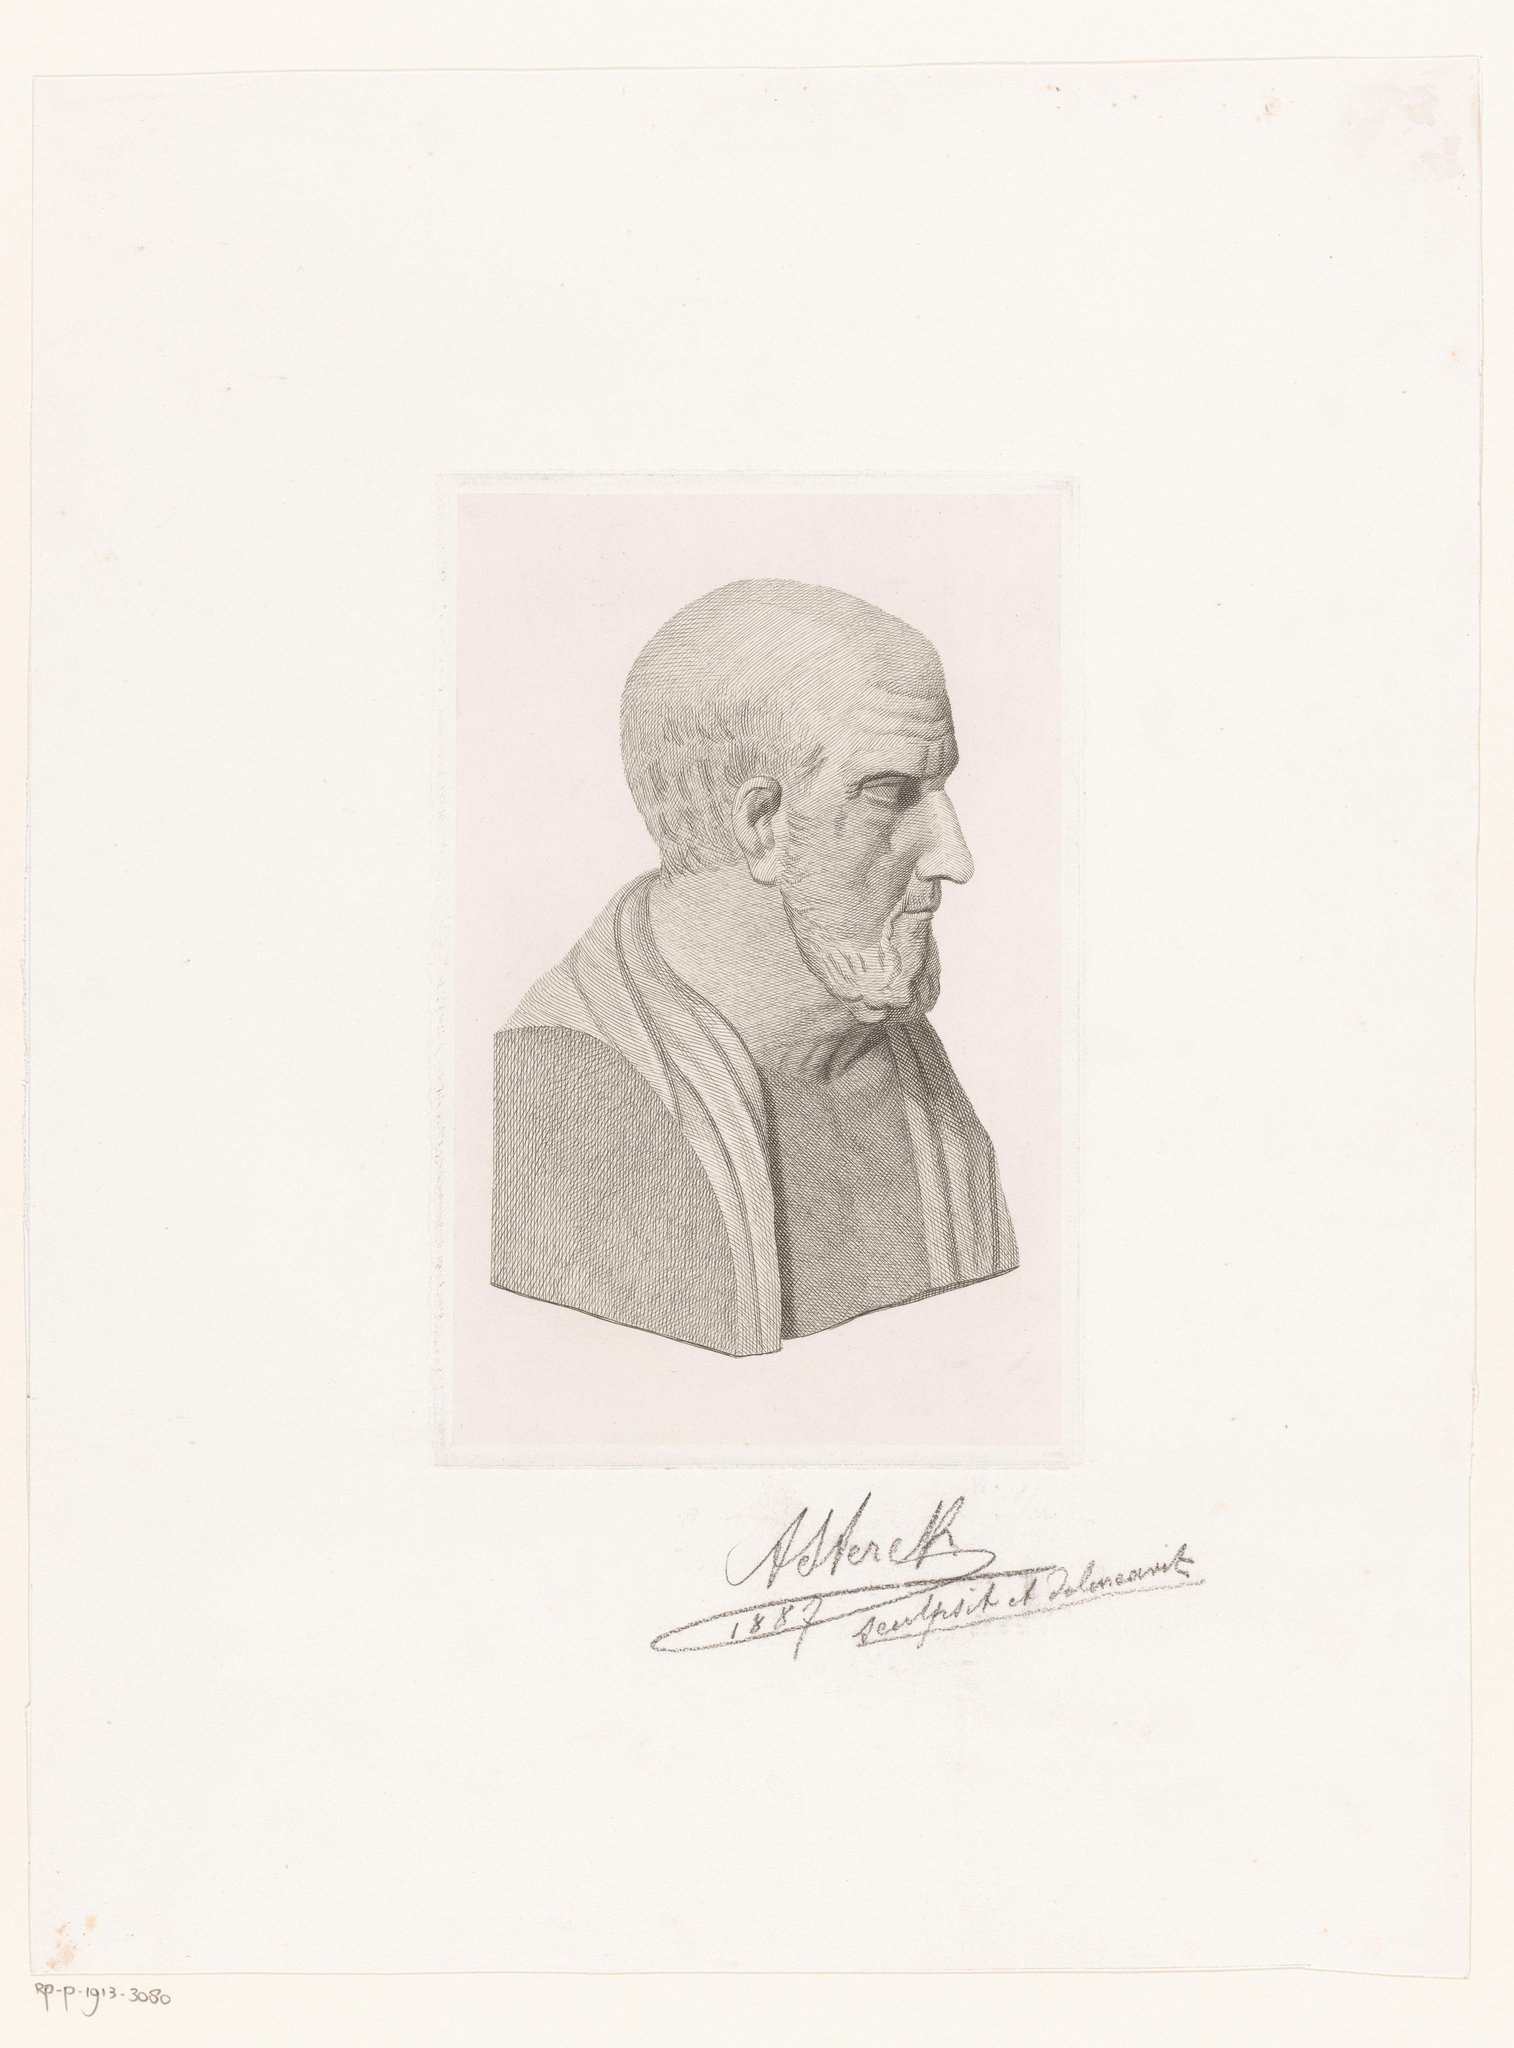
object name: print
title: Buste van een bebaarde man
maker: arthur sterck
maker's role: print maker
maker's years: 1868-1897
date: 1887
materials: paper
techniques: etching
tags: chest, bust, piece of sculpture, reproduction of a piece of sculpture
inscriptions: collector's mark: Lugt 2228